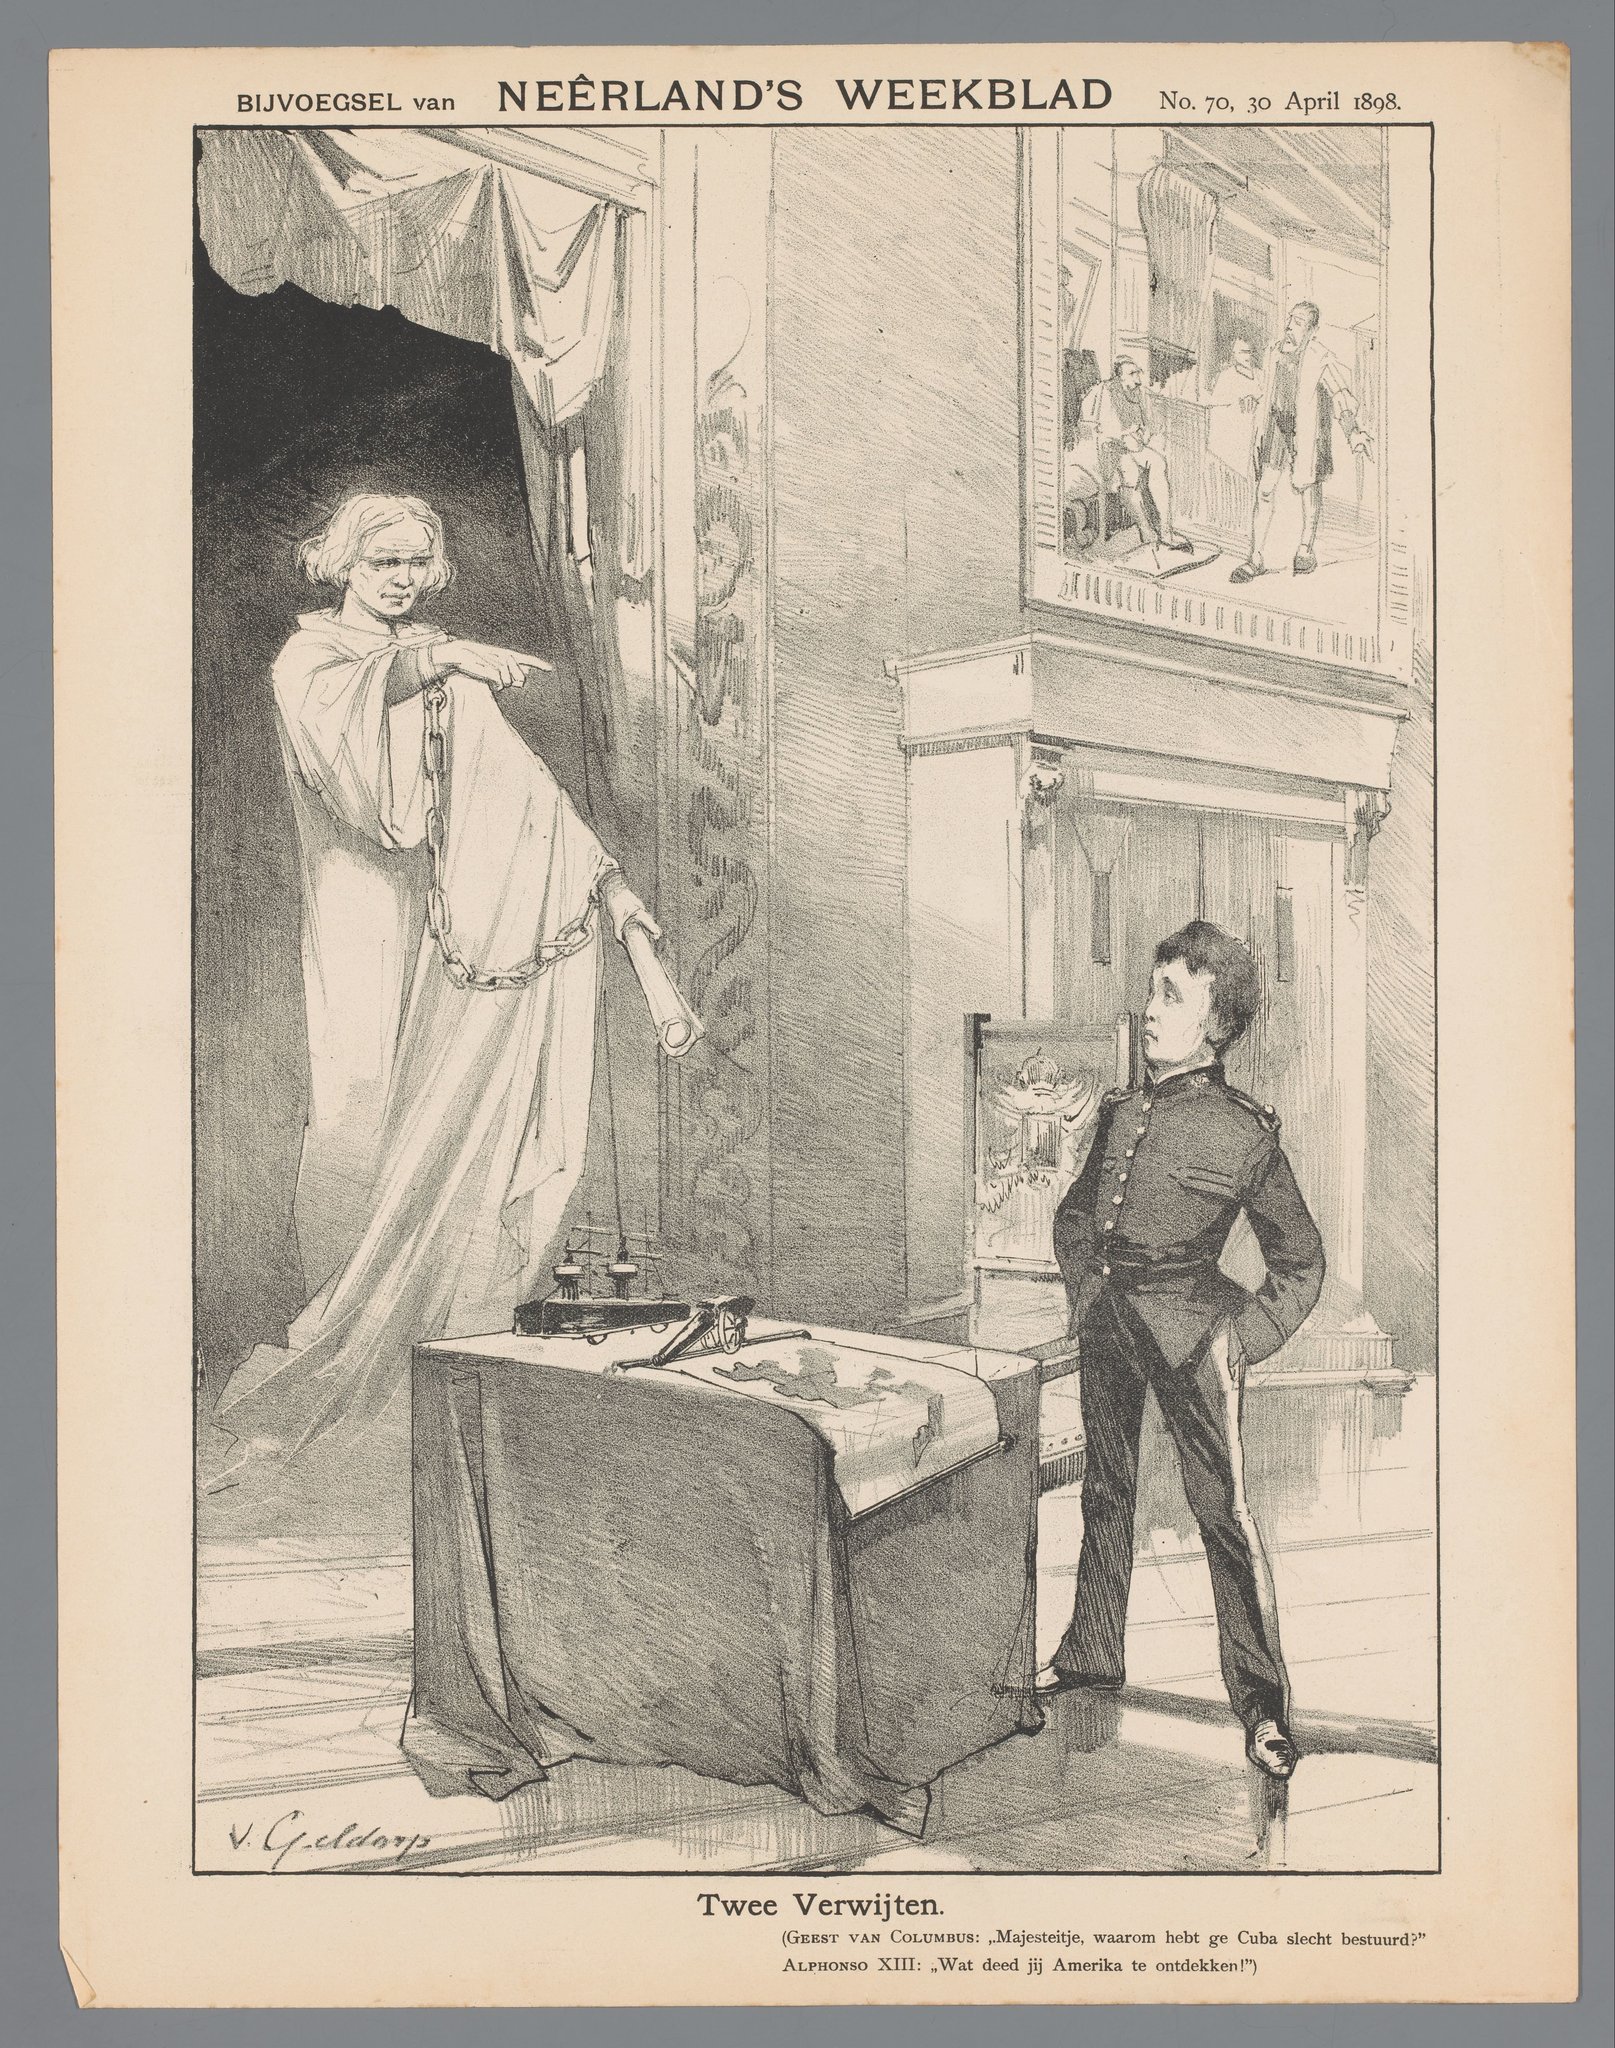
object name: cartoon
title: Twee Verwijten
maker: petrus van geldorp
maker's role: draughtsman, print maker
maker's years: 1872-1939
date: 1898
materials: paper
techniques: lithograph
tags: ruler, sovereign, explorer, political caricatures and satires, united states of america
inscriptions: date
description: Prent uit het bijvoegsel van: Neêrland’s Weekblad, nr. 70, 30 april 1898.